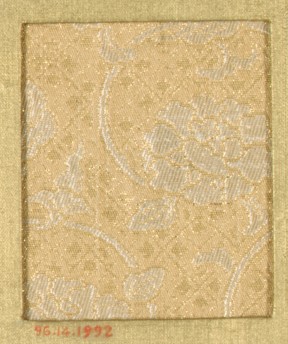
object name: piece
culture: japanese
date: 1701-1900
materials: silk